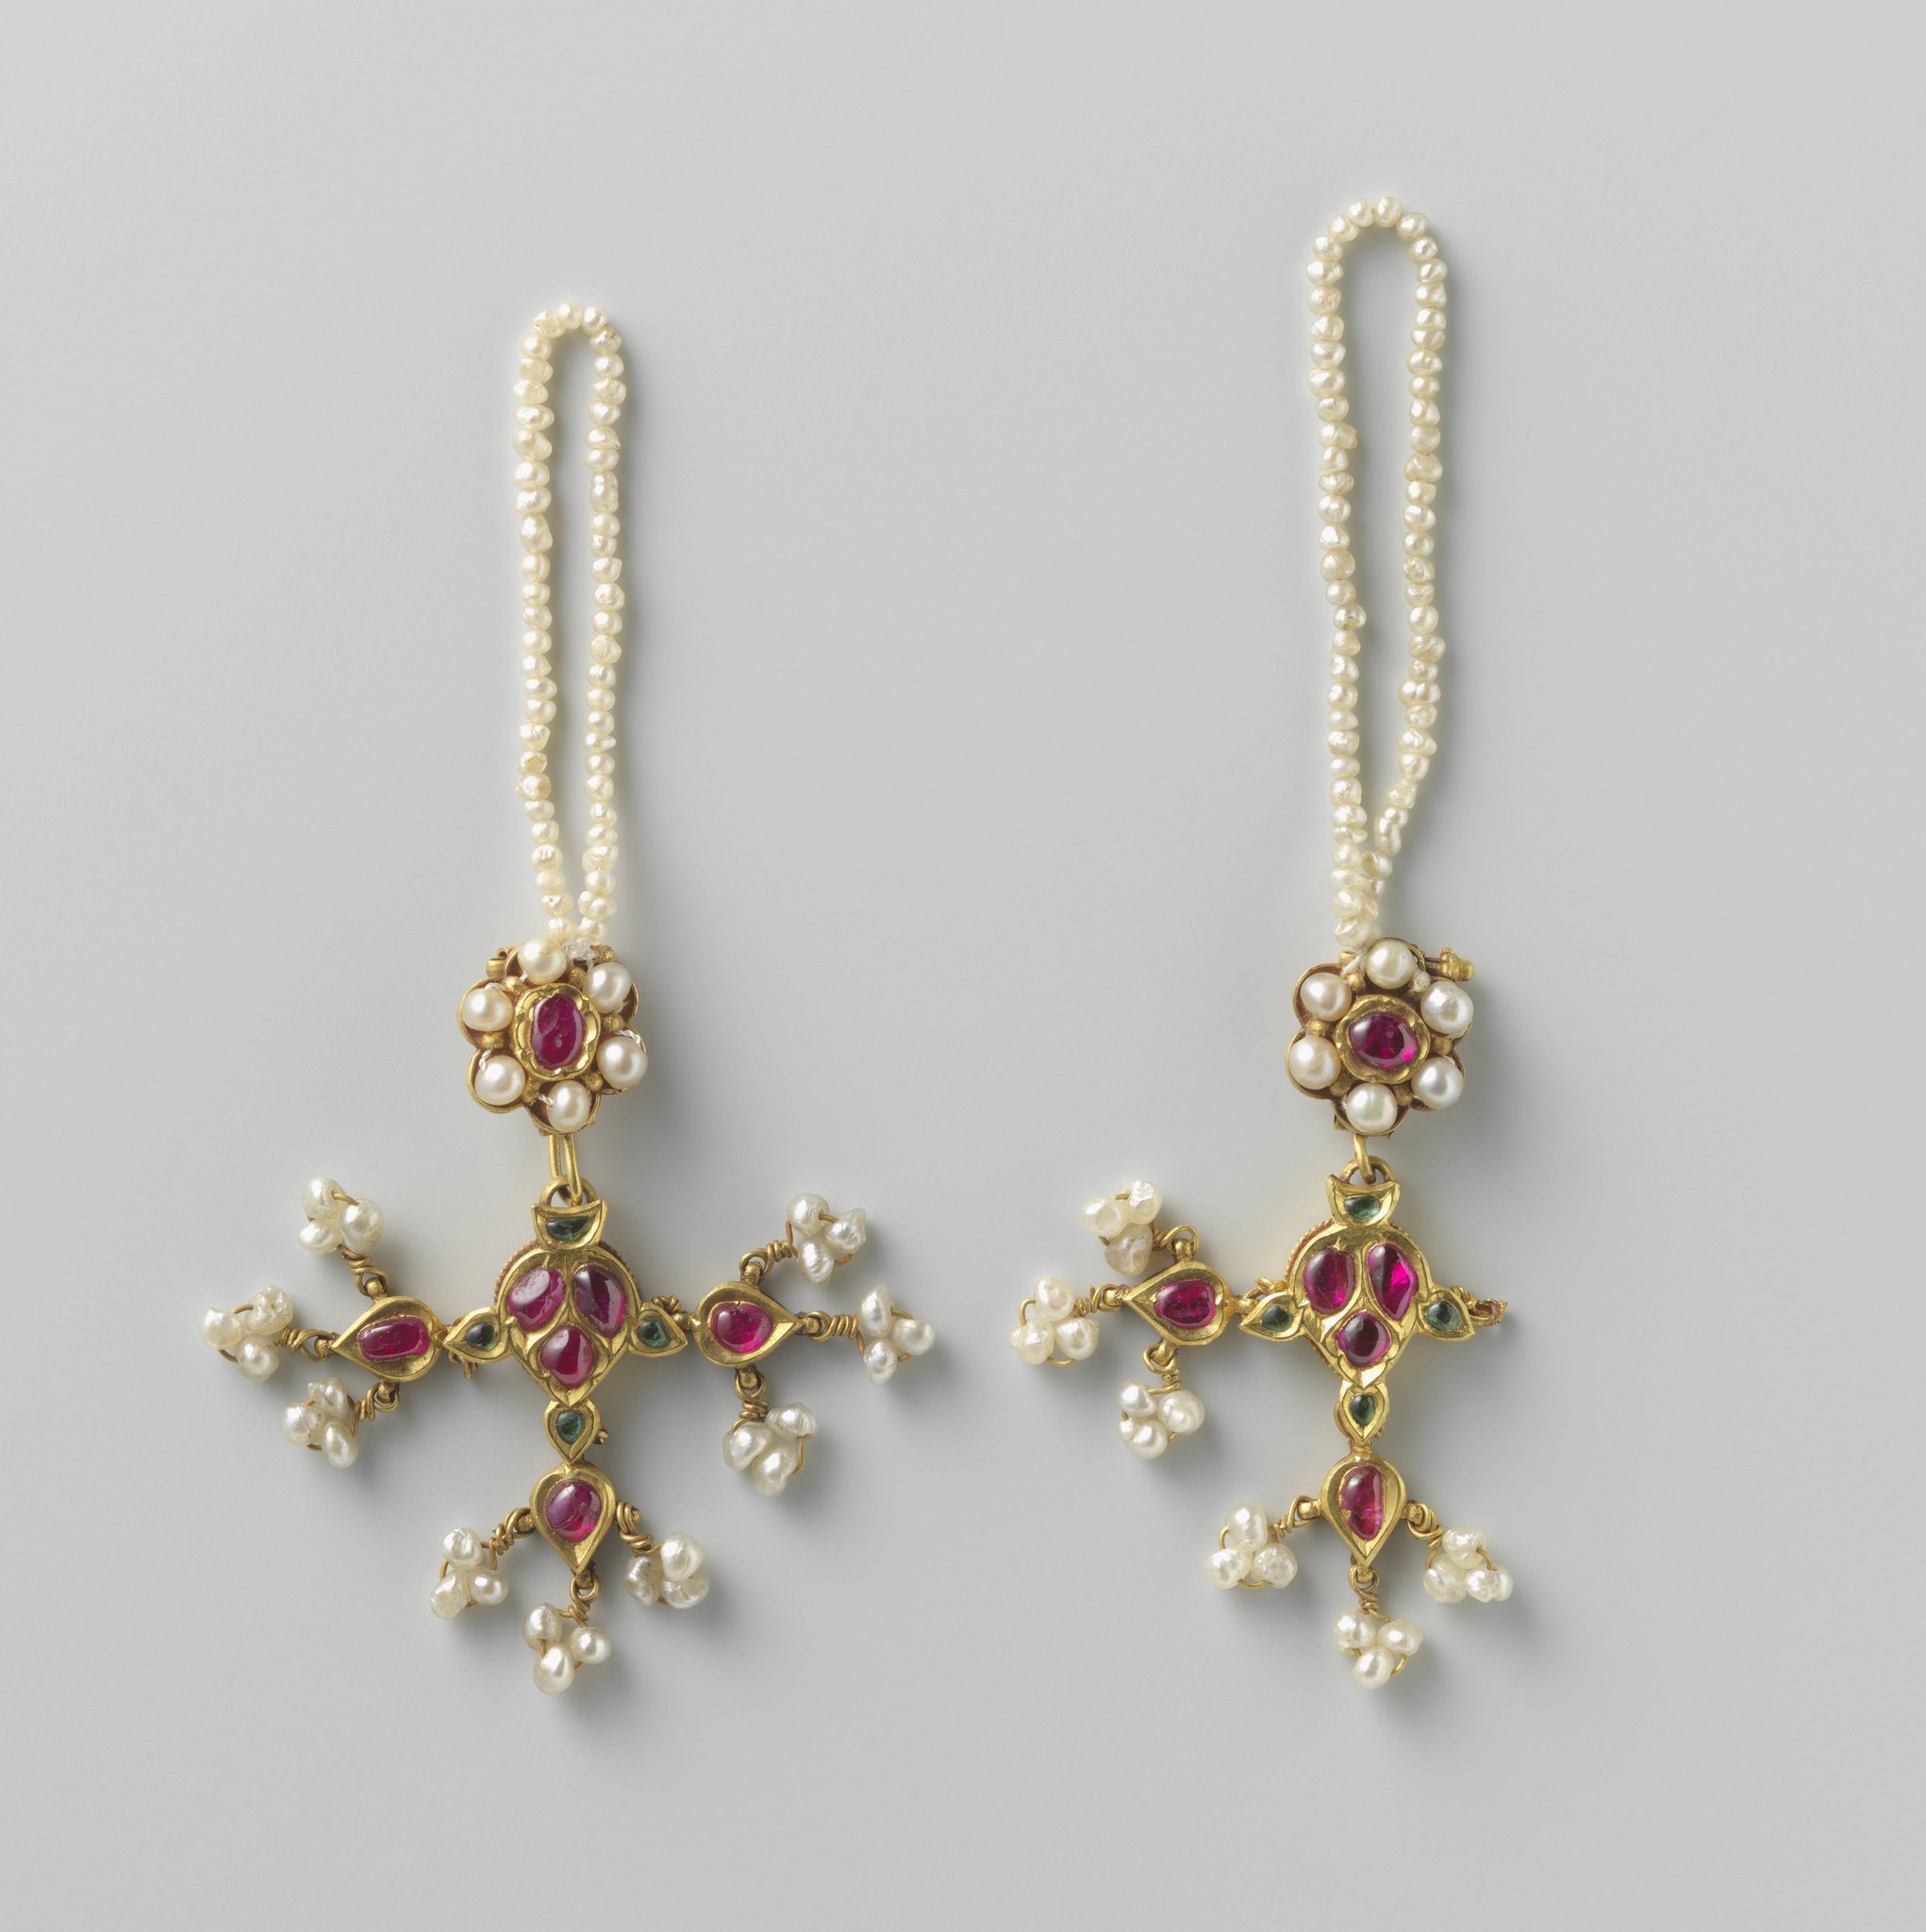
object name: earring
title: Paar oorbellen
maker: Anonymous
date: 1750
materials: gold, pearl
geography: surat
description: Jewellery for Hindu and Moslem women. Forehead ornament. Gold, ruby, emerald, diamond, pearl. Earrings. Gold, ruby, emerald, pearl.